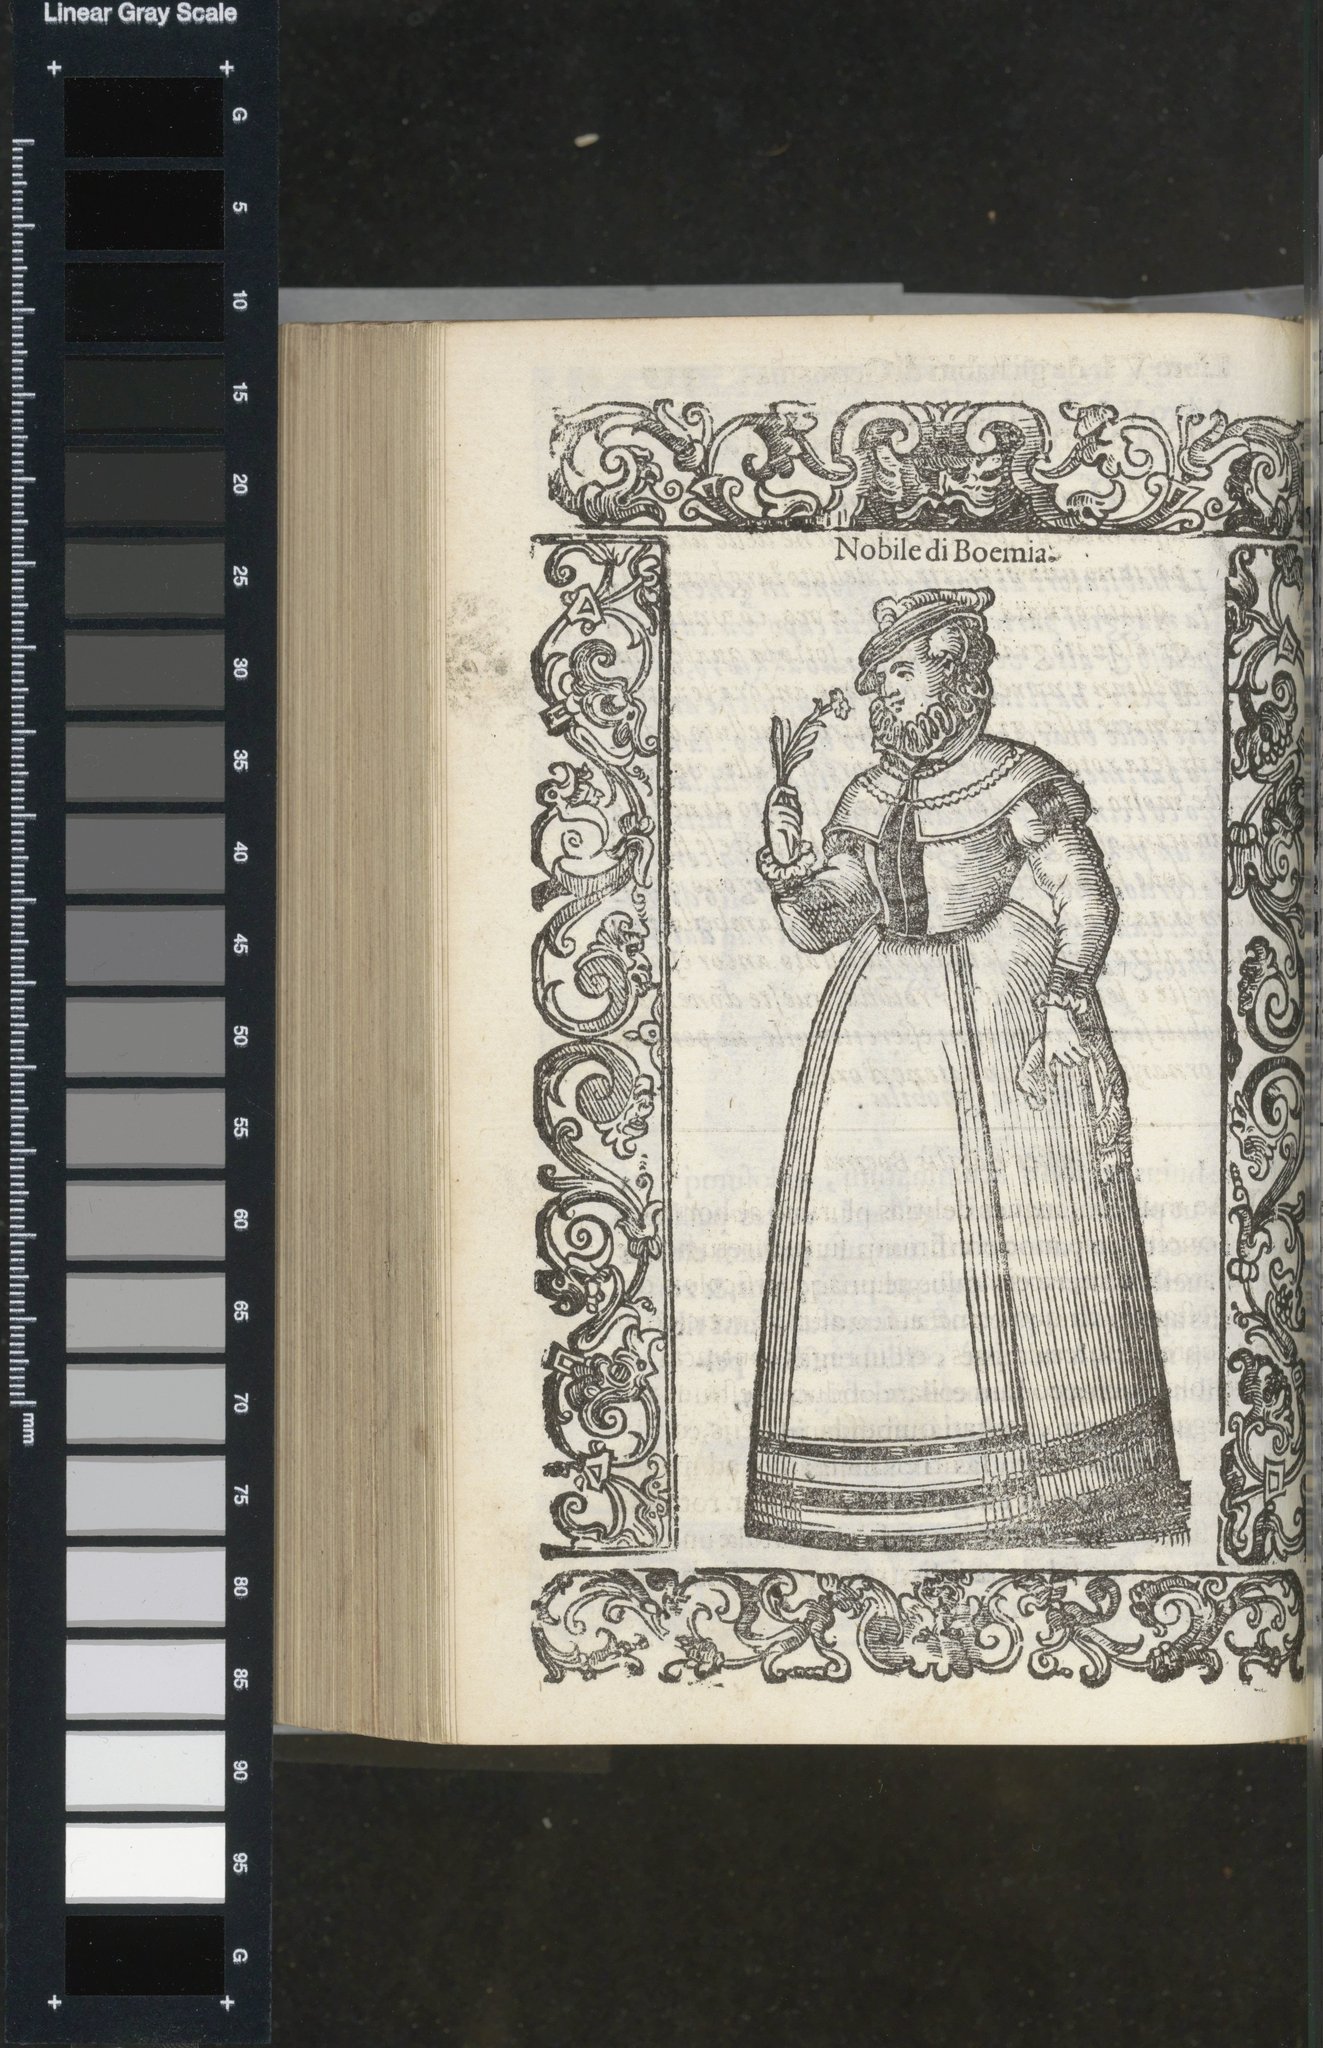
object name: costume print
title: Nobile di Boemia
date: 1598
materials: paper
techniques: woodcut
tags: fashion plates